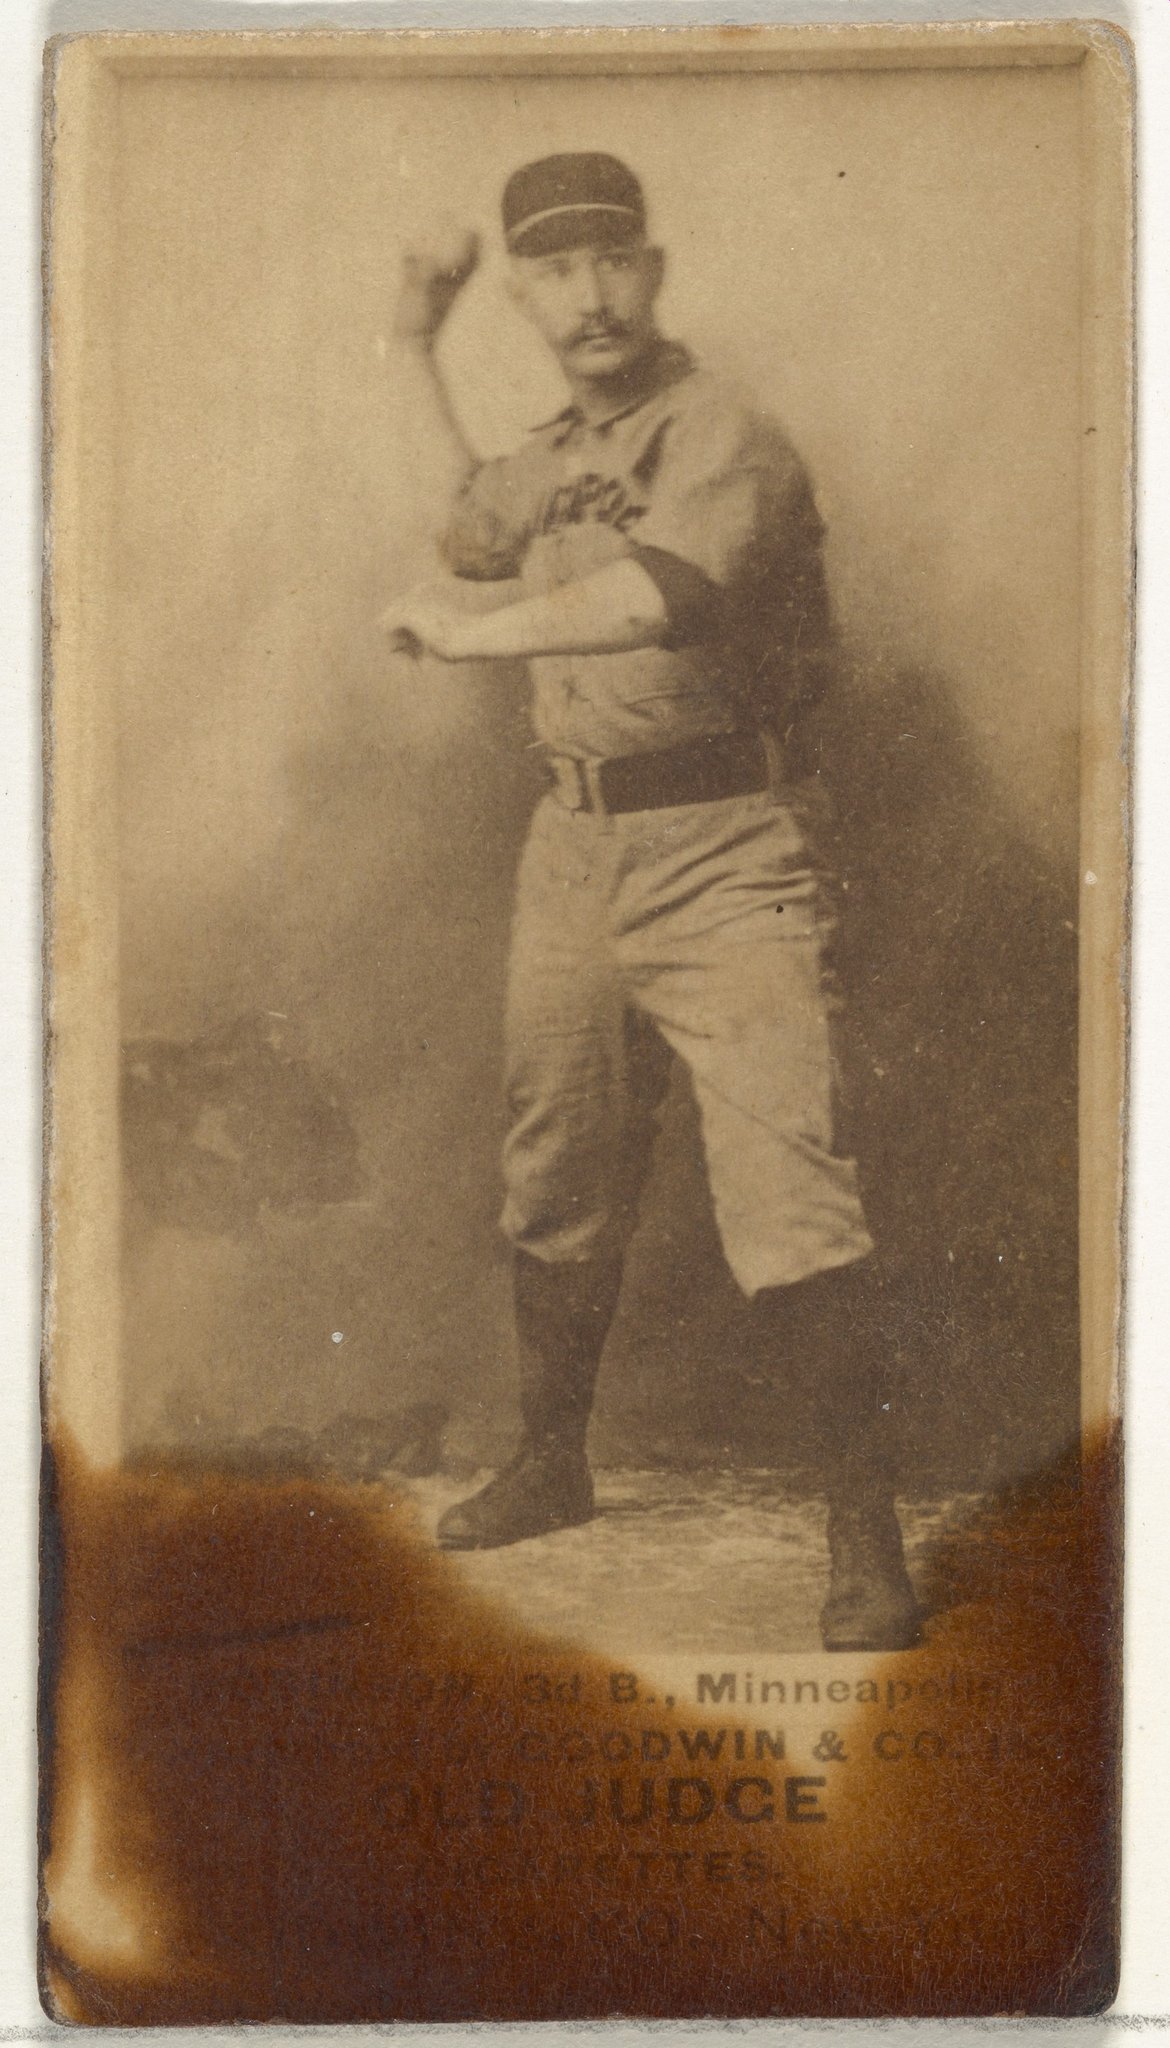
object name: baseball card, photograph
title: Myers C. Robinson, 3rd Base, Minneapolis, from the Old Judge series (N172) for Old Judge Cigarettes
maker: goodwin & company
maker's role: publisher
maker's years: 1850-1950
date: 1887-1890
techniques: albumen silver print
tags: men,portraits,baseball,athletes